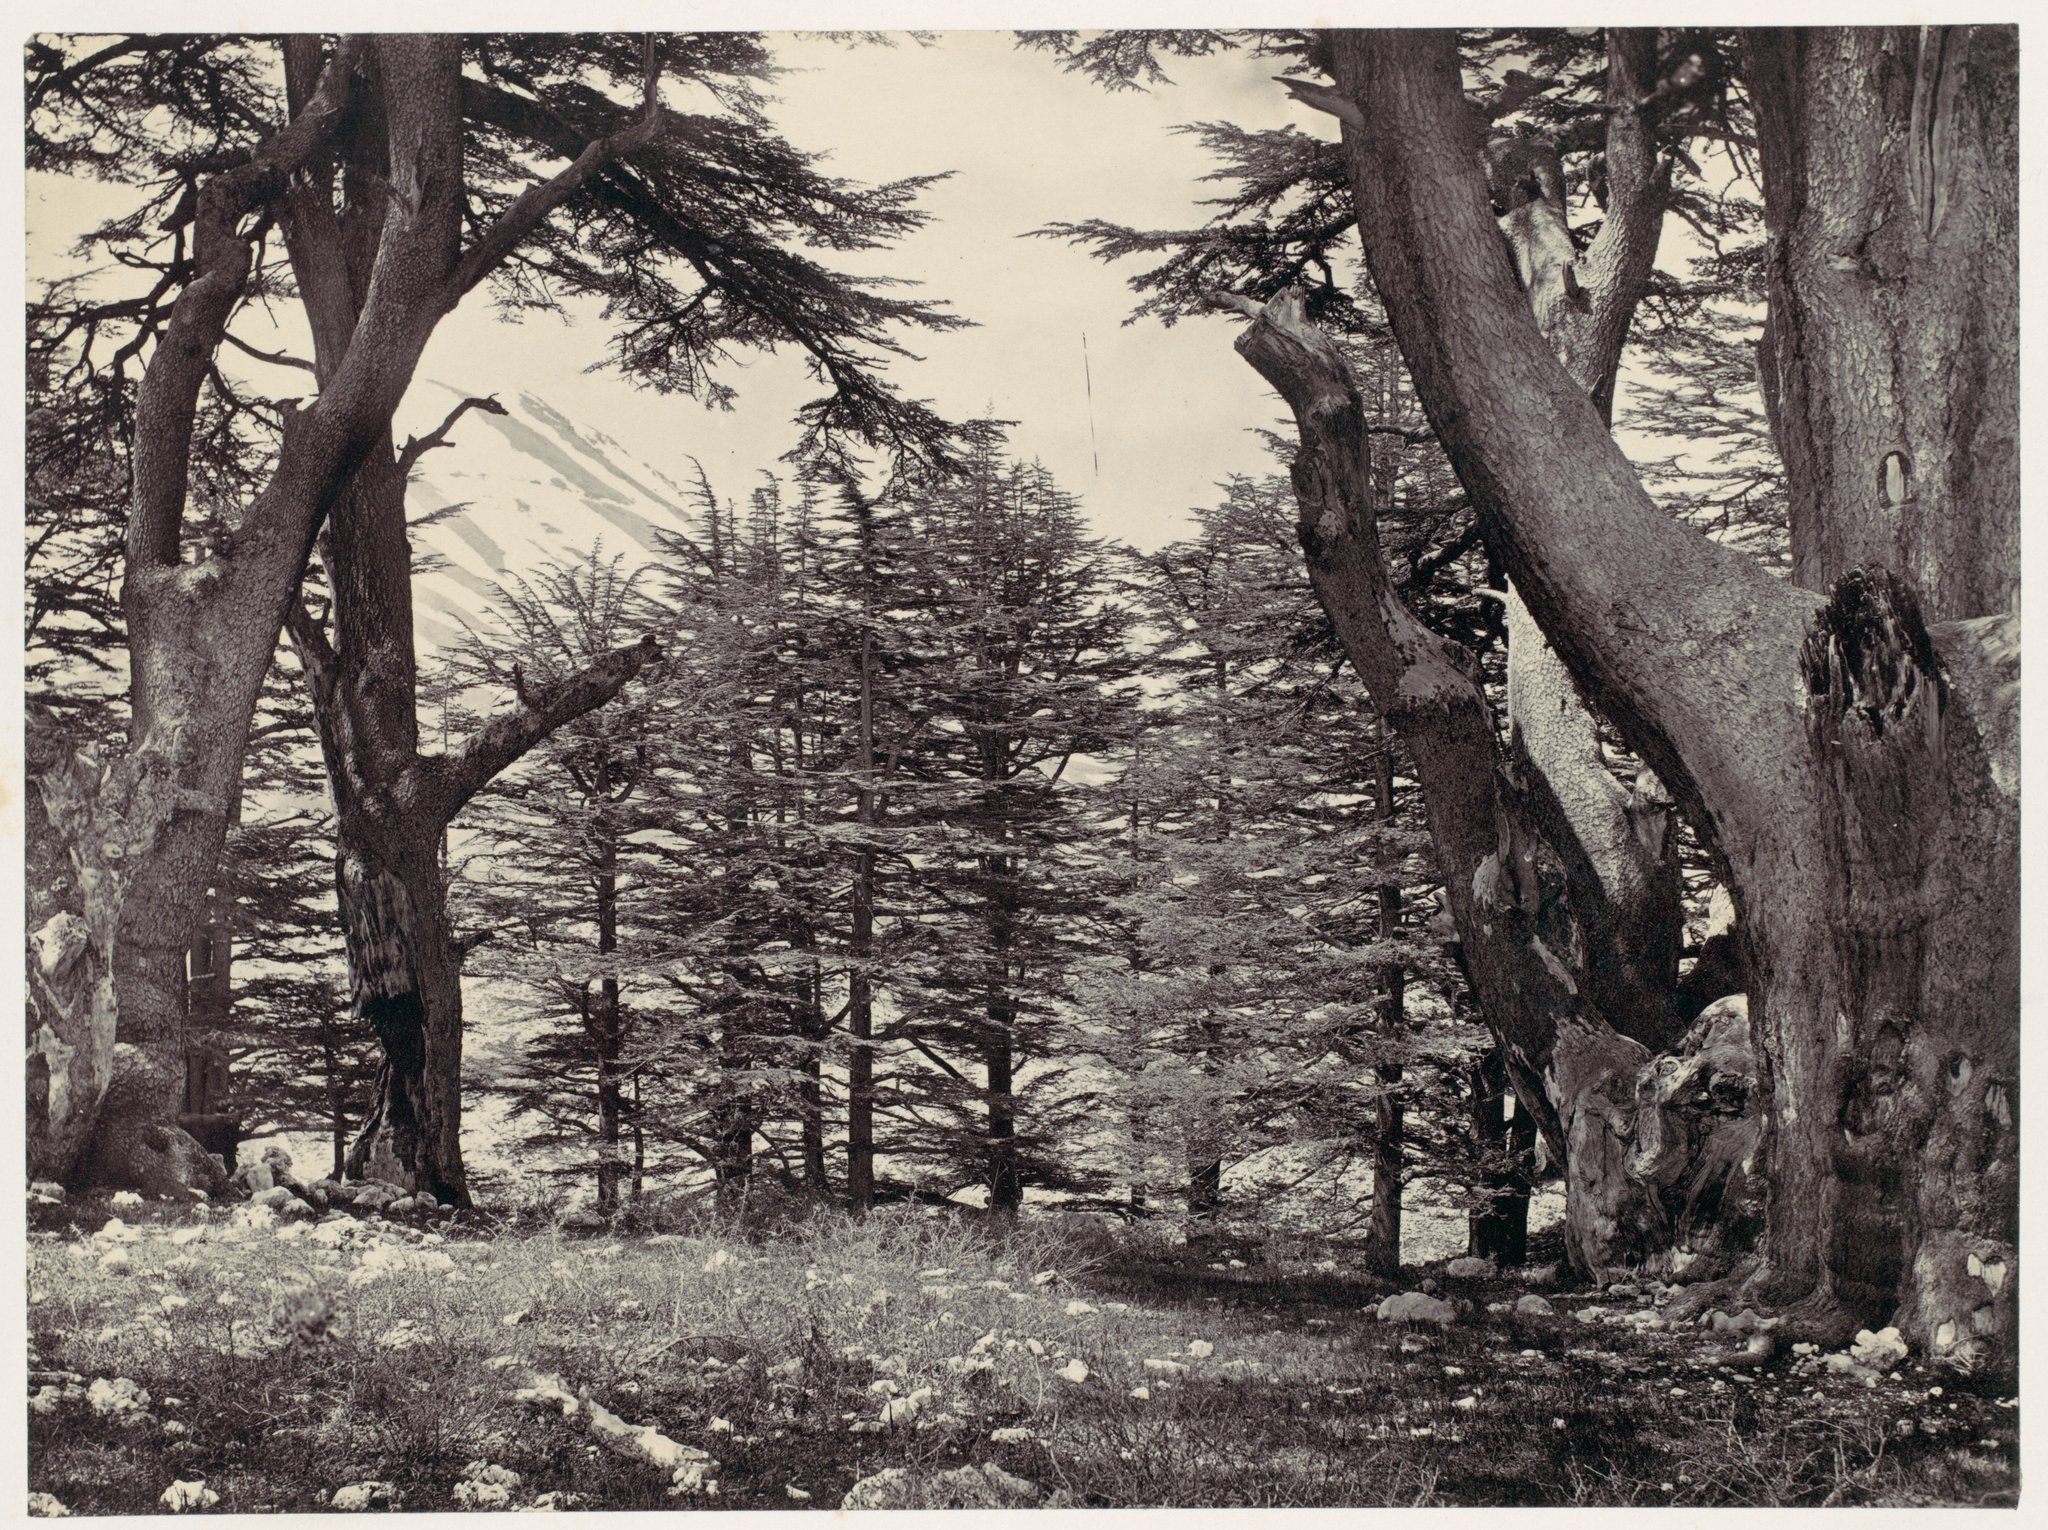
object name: photograph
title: Cedars of Lebanon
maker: francis frith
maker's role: publisher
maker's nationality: english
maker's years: 1822-1898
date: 1857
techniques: albumen silver print, glass negative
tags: trees